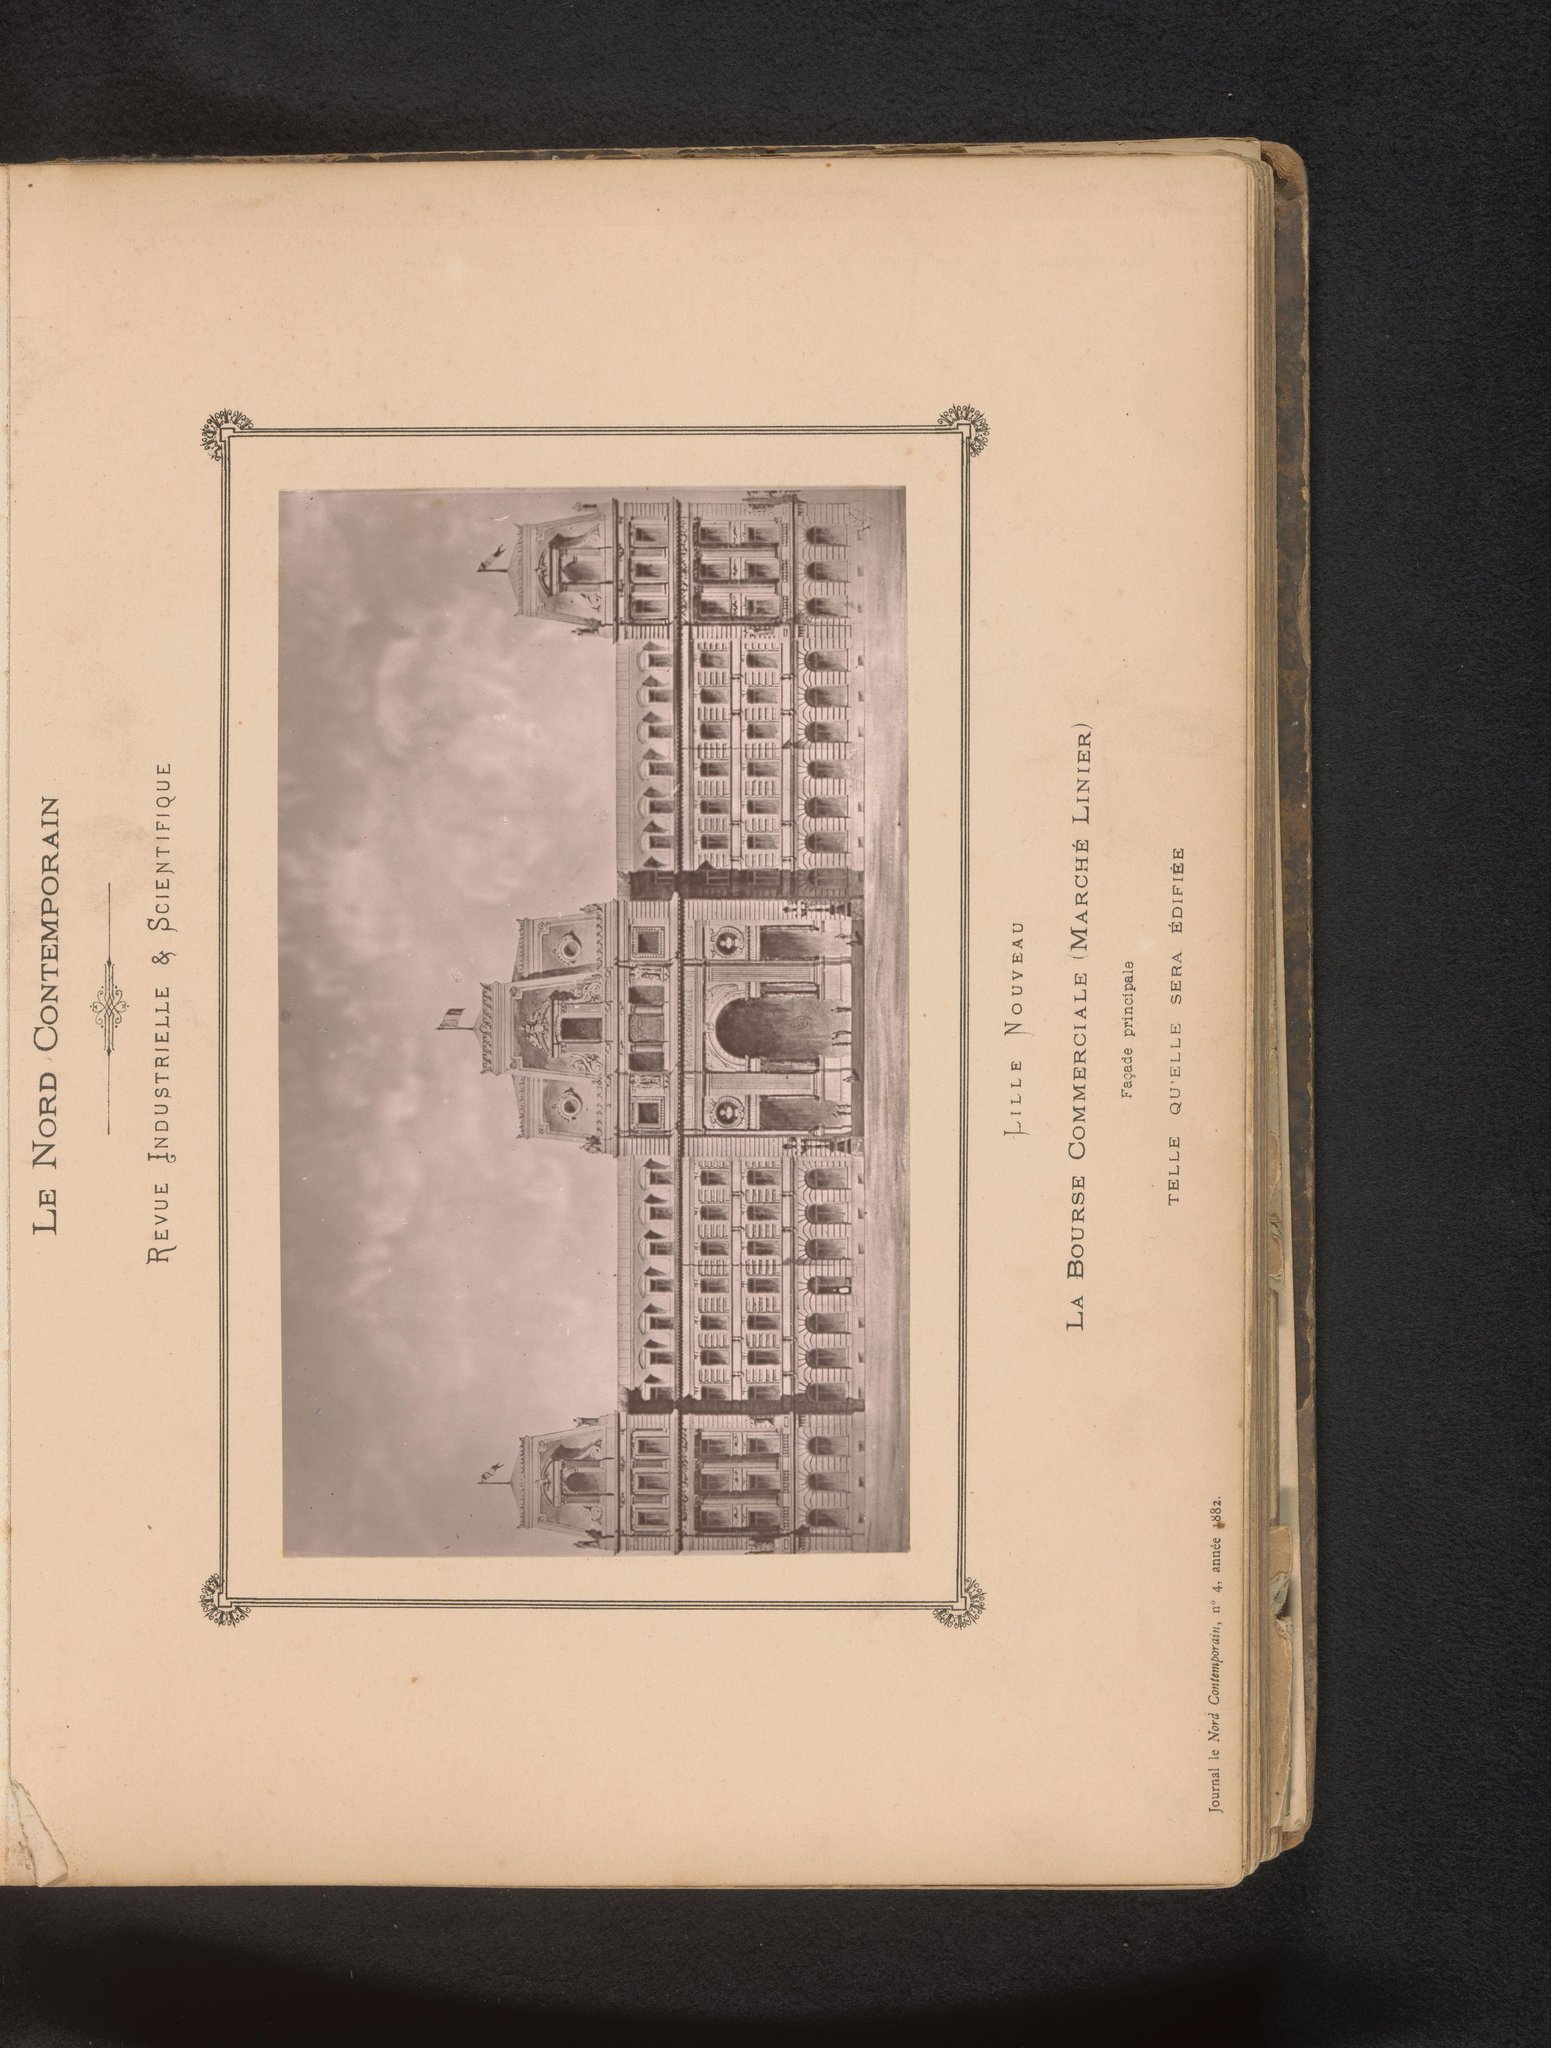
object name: photomechanical print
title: Lille Nouveau, la bourse commerciale (Marché Liner)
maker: Anonymous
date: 1878-1882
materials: paper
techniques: woodburytype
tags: exchange, bourse, lille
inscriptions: inscription: ‘Le Nord Contemporain/ Revue Industrielle & Scientifique’, inscription: ‘Journal le Nord Contemporain, No 4, année 1882’, inscription: ‘Façade principale/ telle qu'elle sera édifiée’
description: Prent op derde ongenummerde pagina na pagina 64.